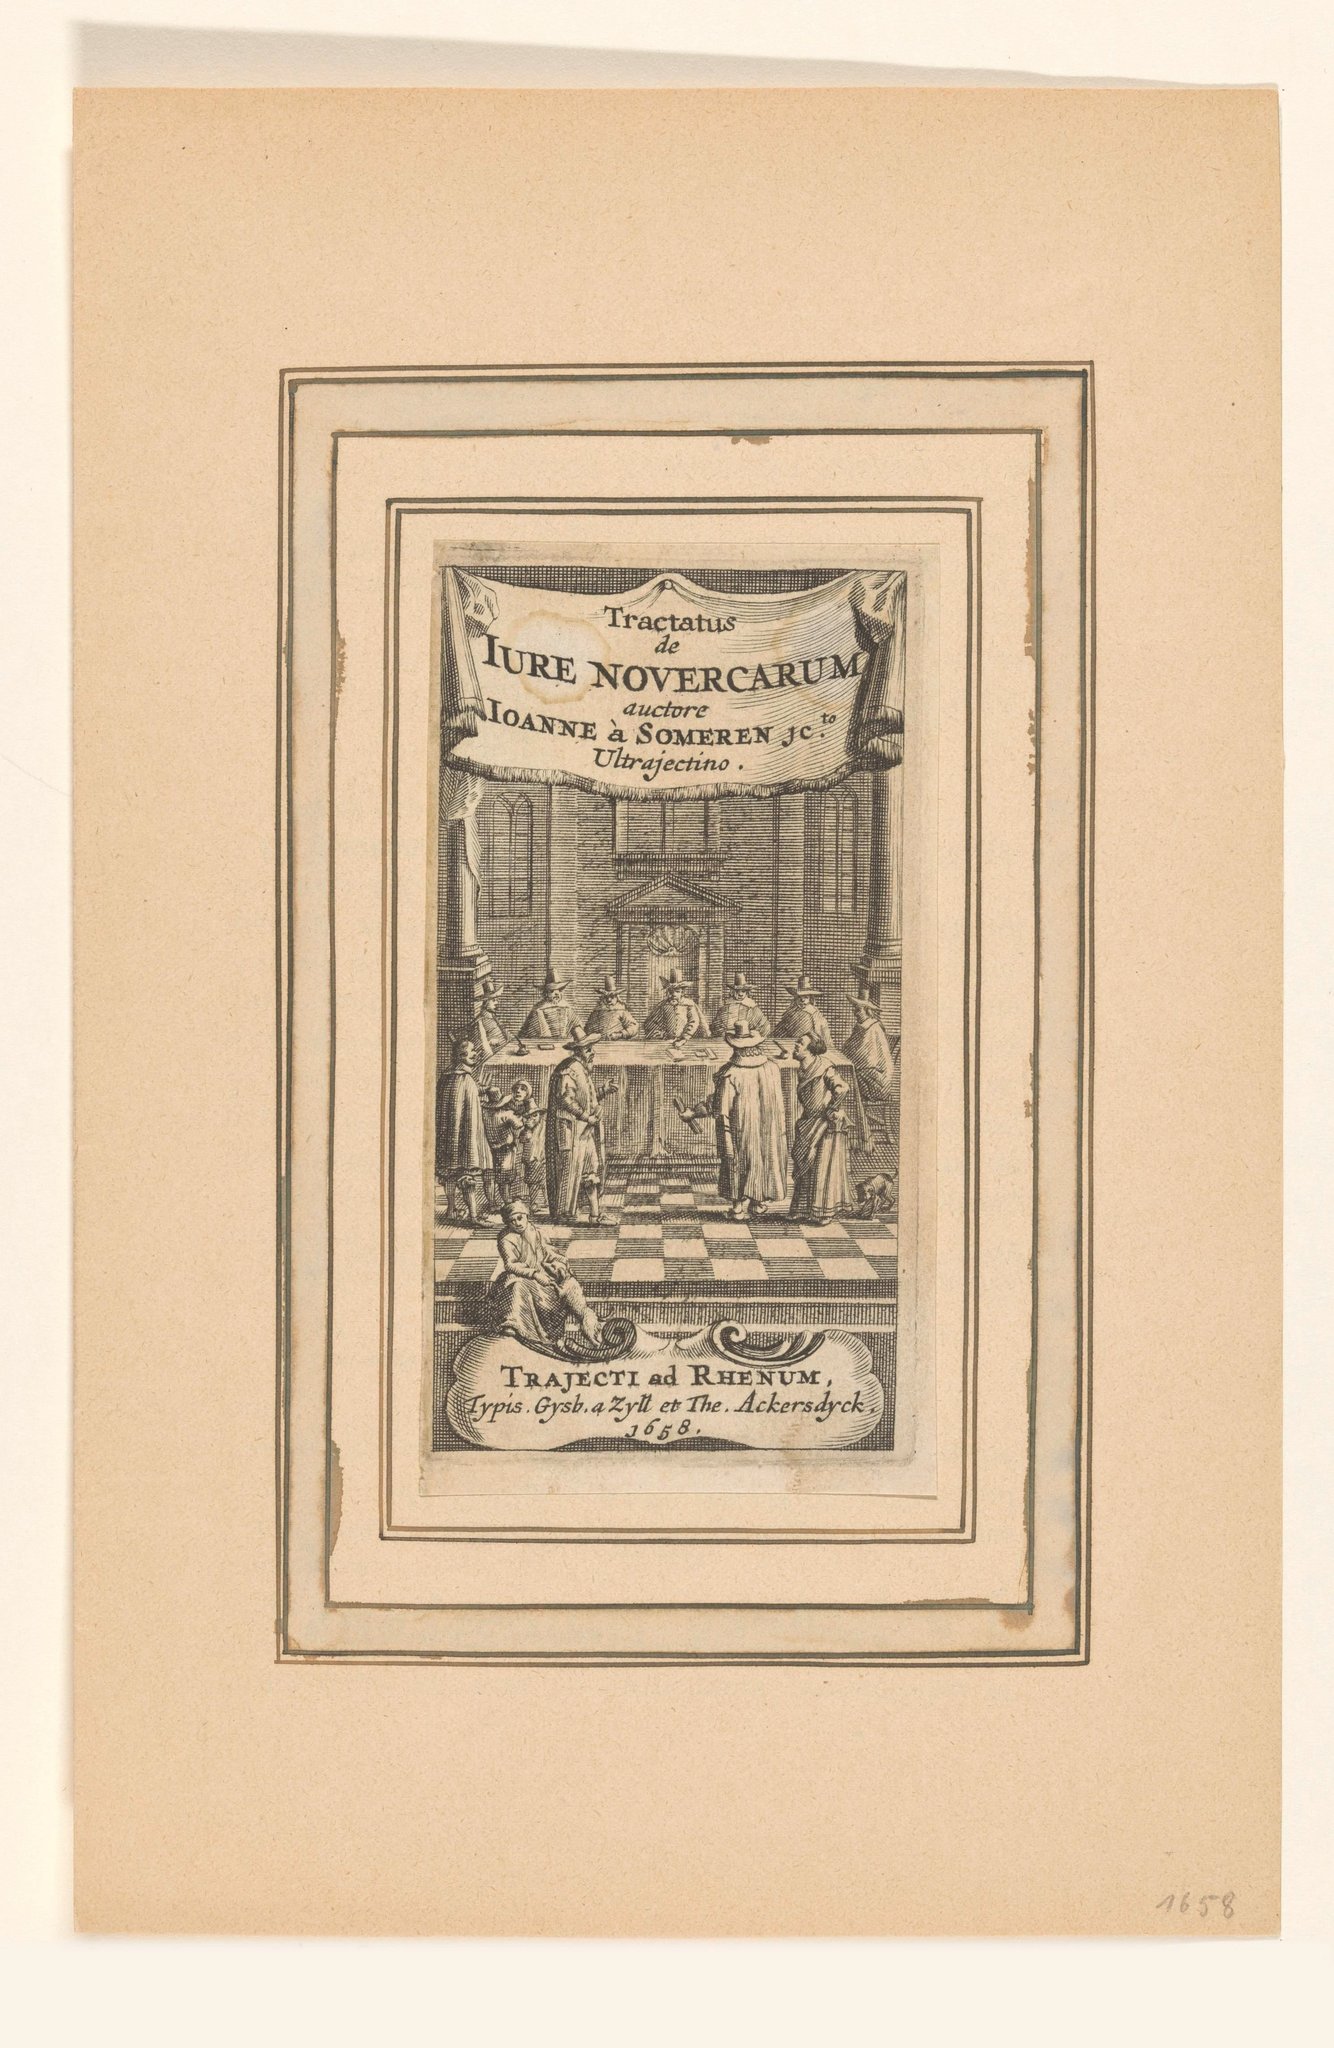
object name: print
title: Titelpagina voor: Johan van Someren, Tractatus de Iure novercarum, 1658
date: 1658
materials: paper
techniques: etching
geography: utrecht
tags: stepmother, court session (court of justice), orphans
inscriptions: collector's mark: Lugt 2228, collector's mark: Lugt 2760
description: Titelpagina voor: Someren, Johan van. Tractatus de Iure novercarum. Utrecht: Zijll, Gijsbert van en Ackersdijck, Dirck van, 1658.